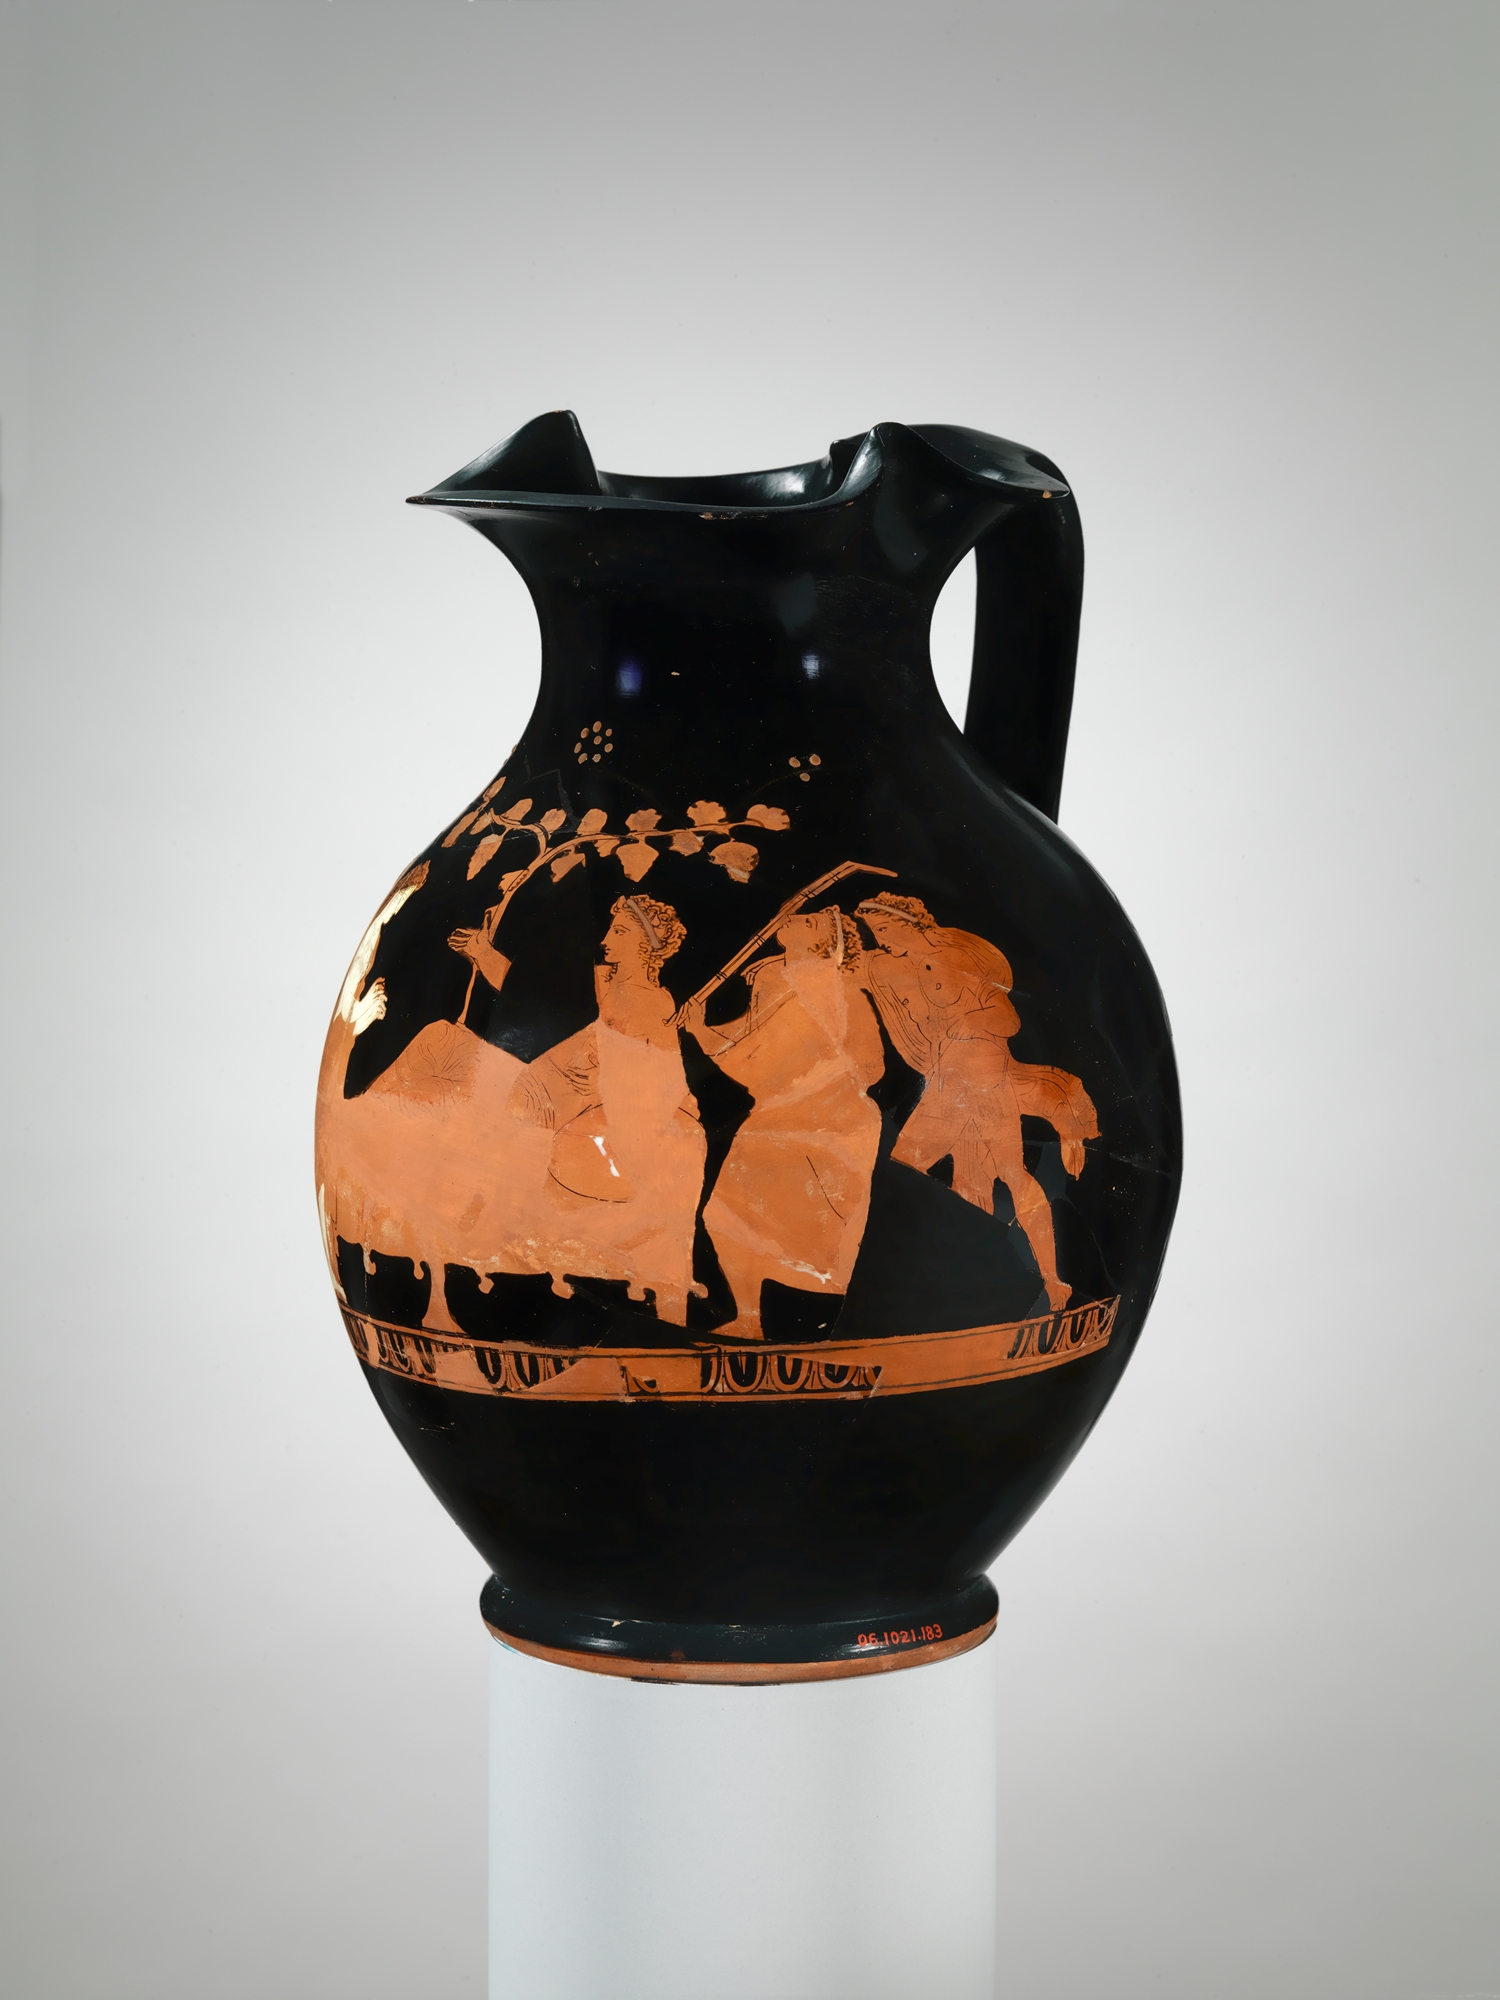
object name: oinochoe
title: Terracotta oinochoe (jug)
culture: greek, attic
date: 400-301 BCE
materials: terracotta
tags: men,women,dionysus